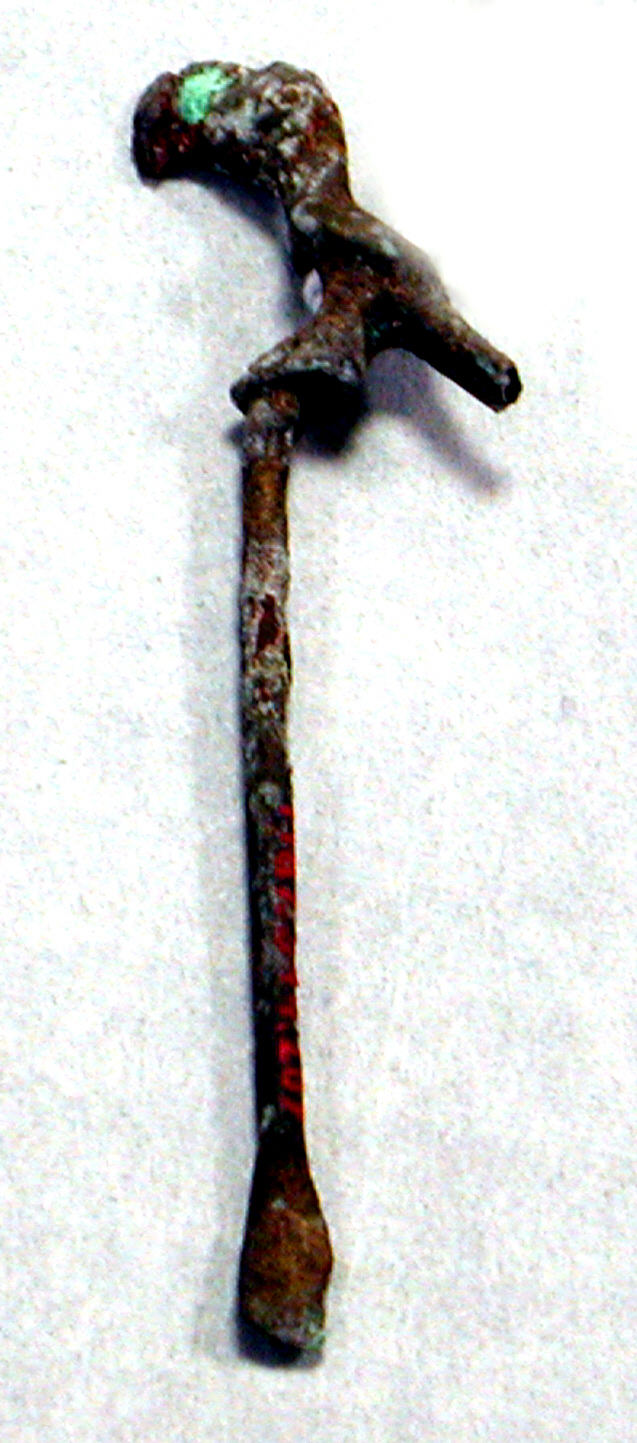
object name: lime spoon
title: Copper Lime Spoon with Bird Top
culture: inca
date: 1401-1600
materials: copper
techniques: casting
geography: peru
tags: birds